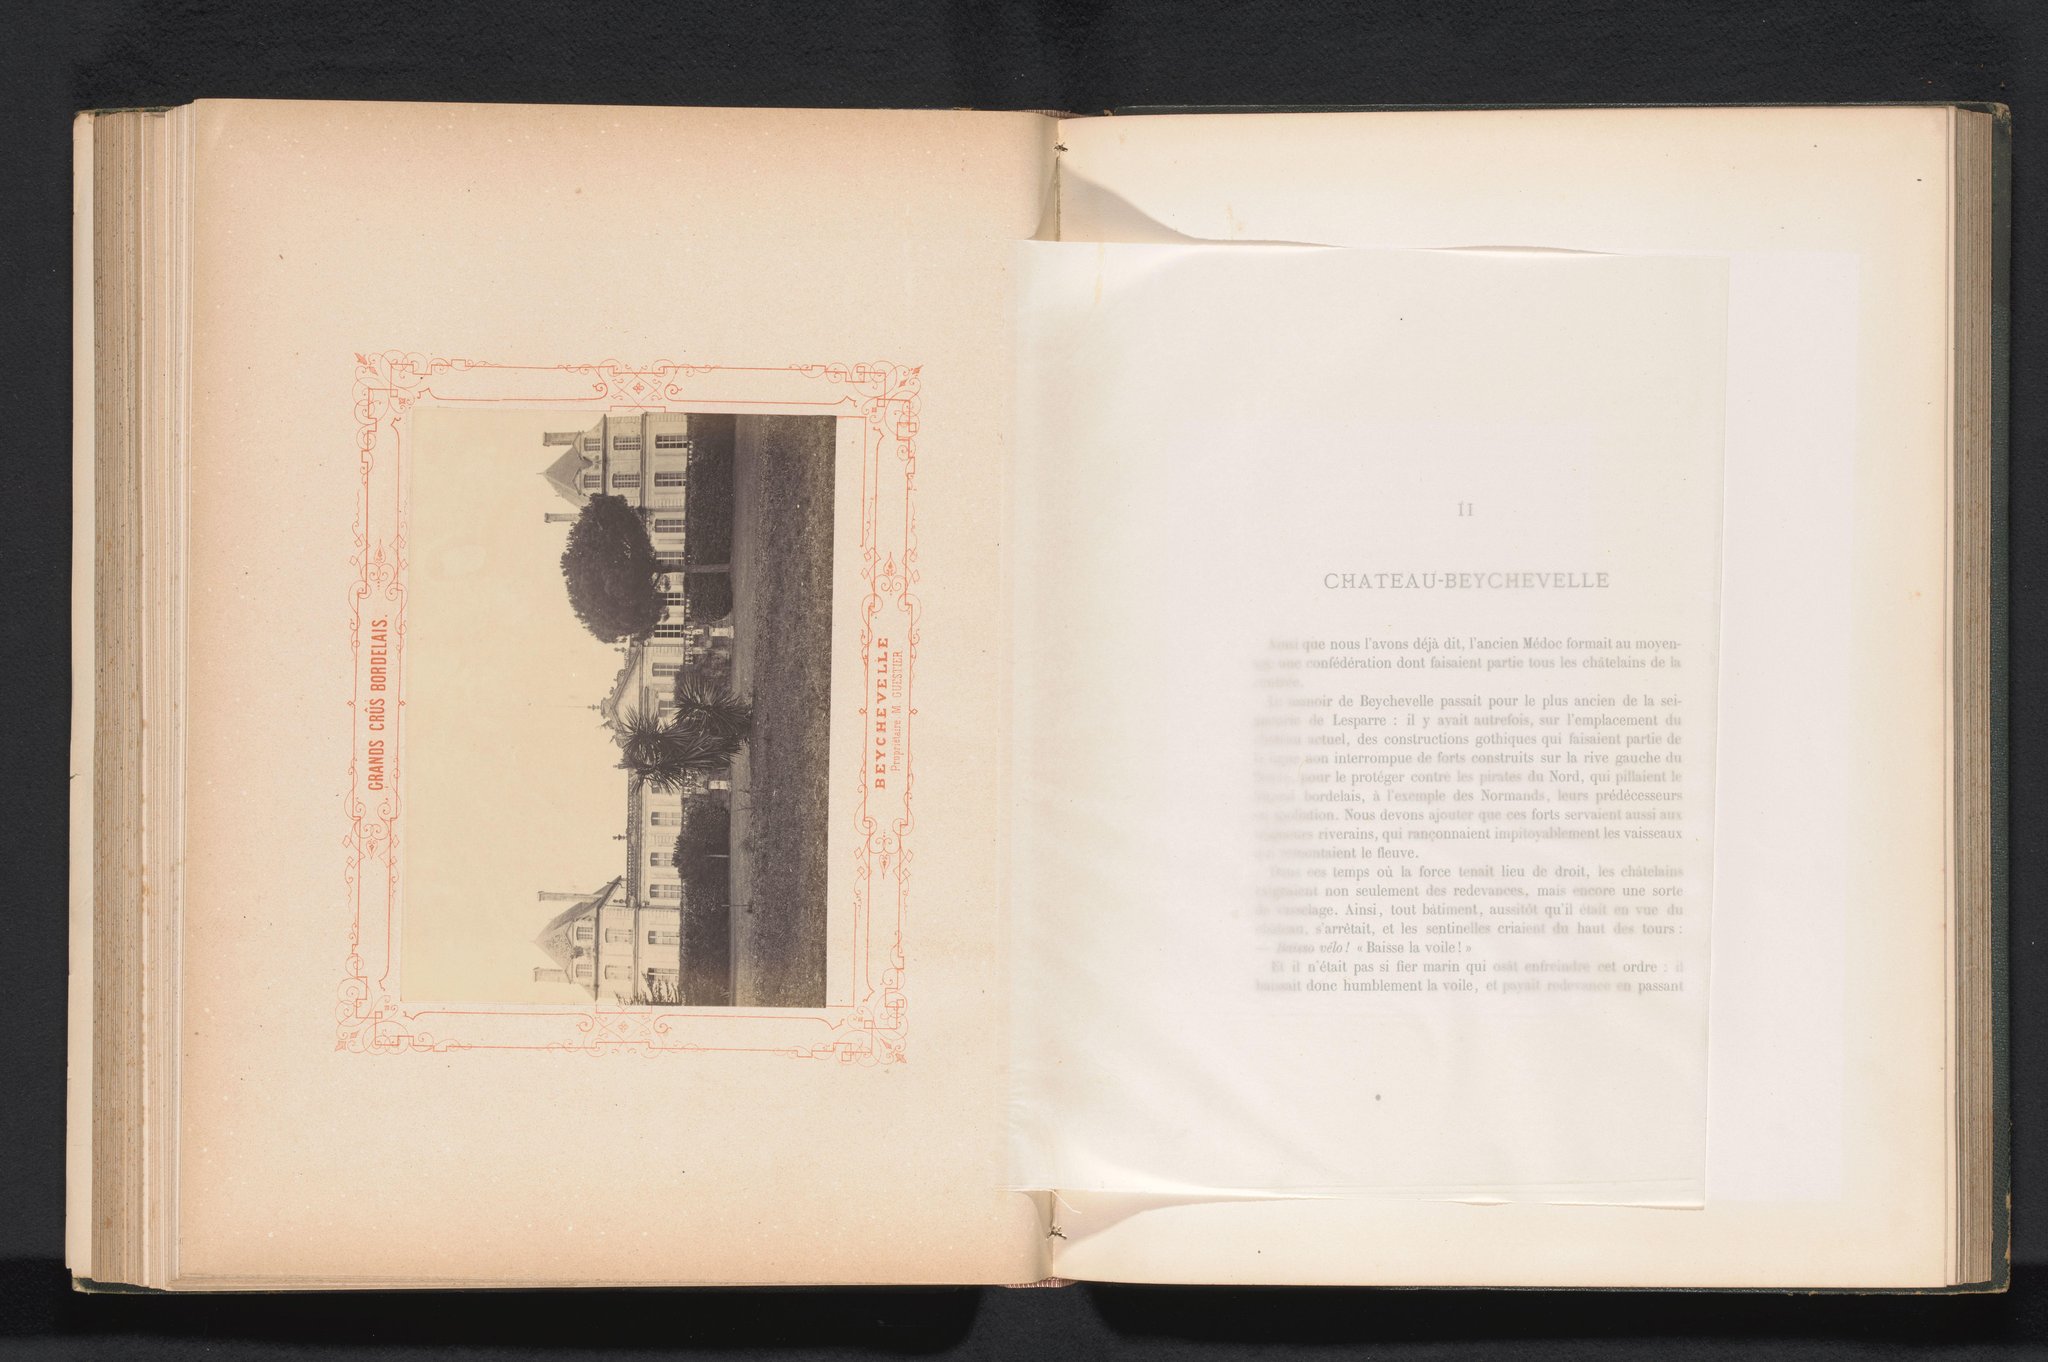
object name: photograph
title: Grands Crûs Bordelais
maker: alfred danflou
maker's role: fotograaf, schrijver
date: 1862-1867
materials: photographic support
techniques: albumen print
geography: saint-julien-beychevelle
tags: castle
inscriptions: inscription: ‘Propriétaire: M. GUESTIER.’